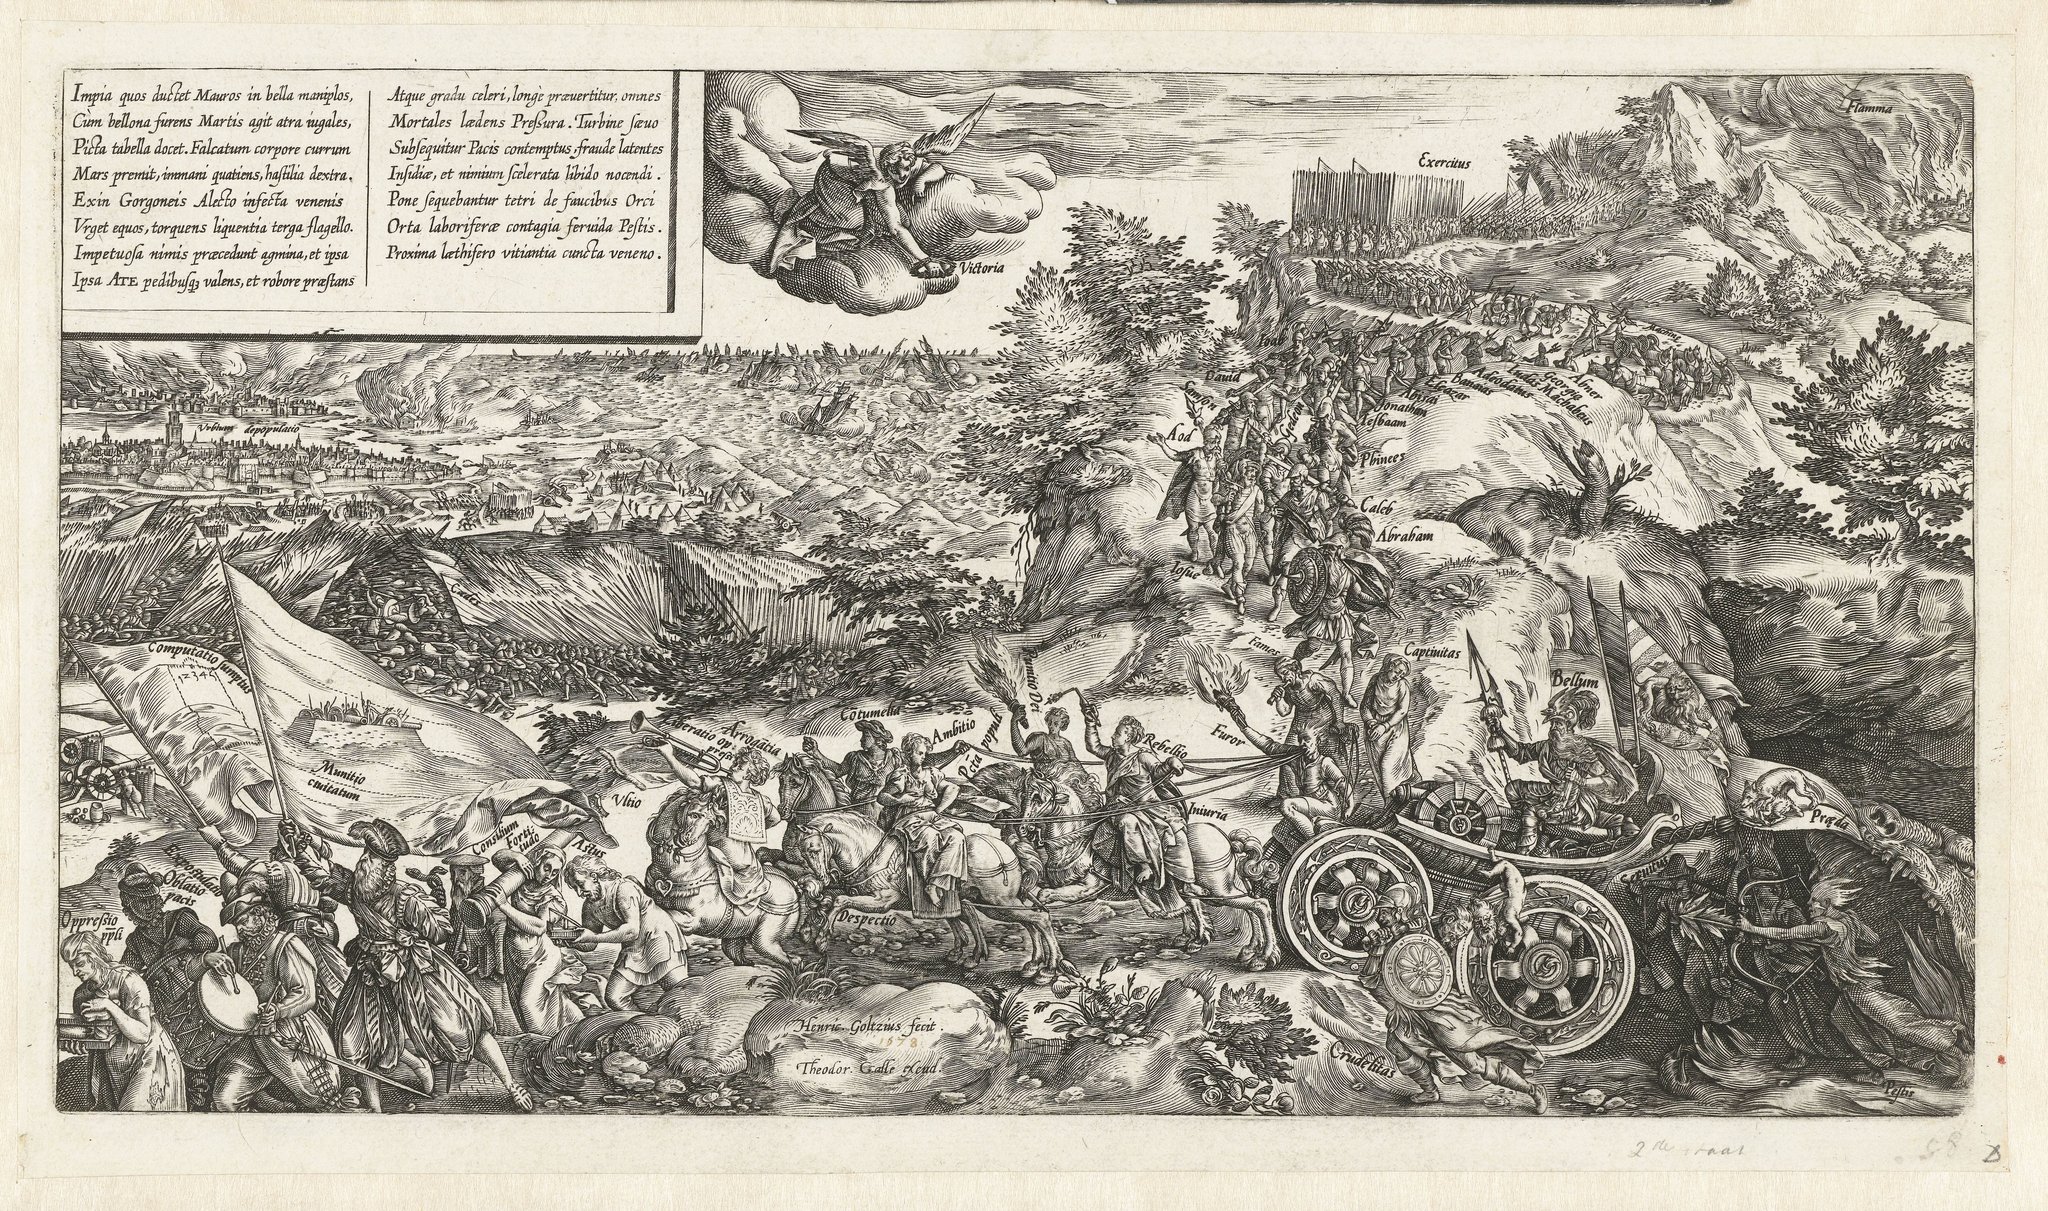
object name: print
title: De triomfwagen van de Oorlog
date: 1578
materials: paper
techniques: engraving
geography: haarlem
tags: symbols, allegories of war; 'guerra' (ripa)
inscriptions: collector's mark: Lugt 240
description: Allegorie op de oorzaken en gevolgen van de oorlog. De personificatie van de Oorlog (Bellum) rijdt op een zegewagen getrokken door vier paarden, vooraan een stoet van personificaties van zaken die voorafgaan aan het uitbreken van de oorlog. Van boven uit de bergen komt een stoet met helden en beroemde legeraanvoerders uit het Oude Testament. Links het land en de zee geteisterd door oorlog. In de wolken de personificatie van de overwinning (Victoria) met een lauwerkrans. In de cartouche linksboven een Latijnse tekst.